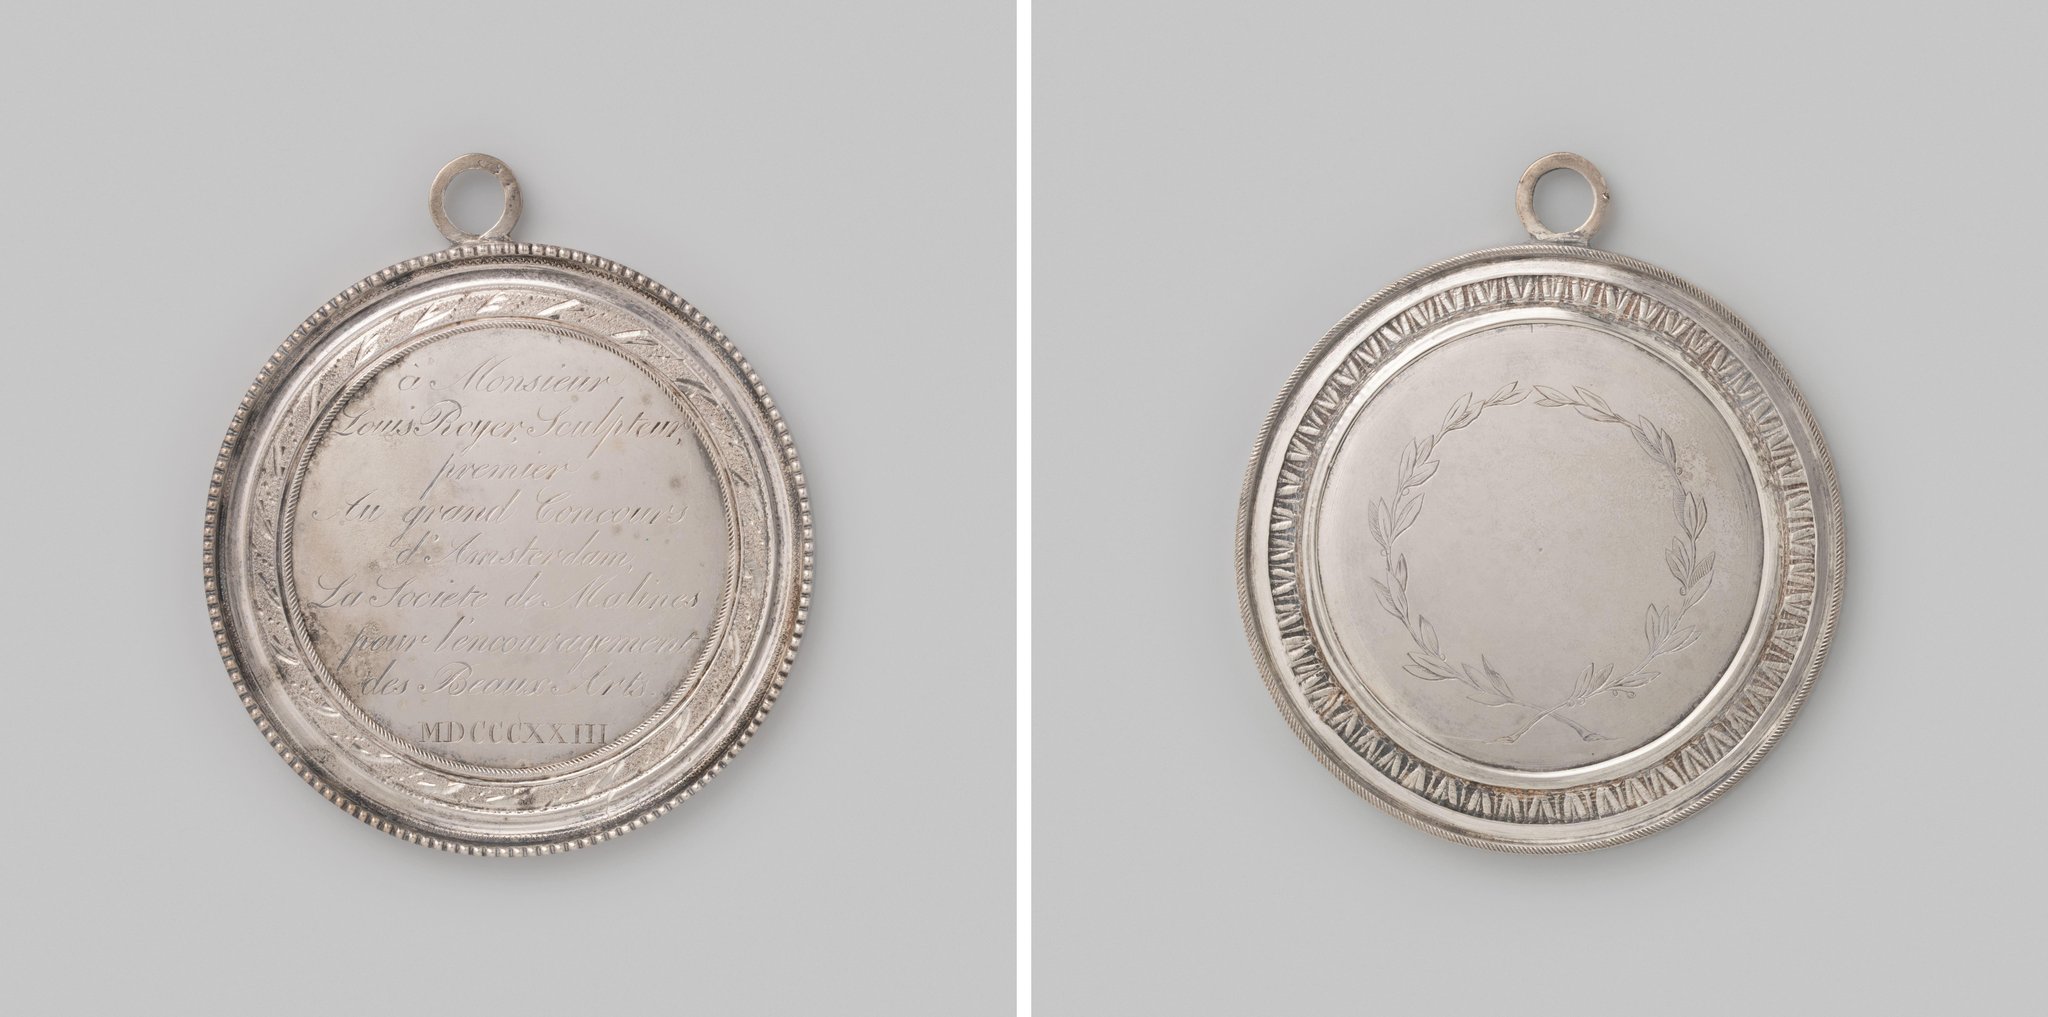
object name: honorary medal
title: Honorary Medal Awarded Louis Royer for Winning the Prix de Rome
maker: Anonymous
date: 1823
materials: silver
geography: mechelen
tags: draughtsman, sculptor, louis royer, amsterdam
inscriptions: inscription: ‘à Monsieur / Louis Royer, Sculpteur, / premier / Au grand Concours / d’Amsterdam / La Societié de Malines / pour l’encouragement / des Beaux Arts./ MDCCCXXIII’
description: Zilveren penning met aan weerszijden rijk versierde rand en opschriften, met draagoog en zilverkeuren.